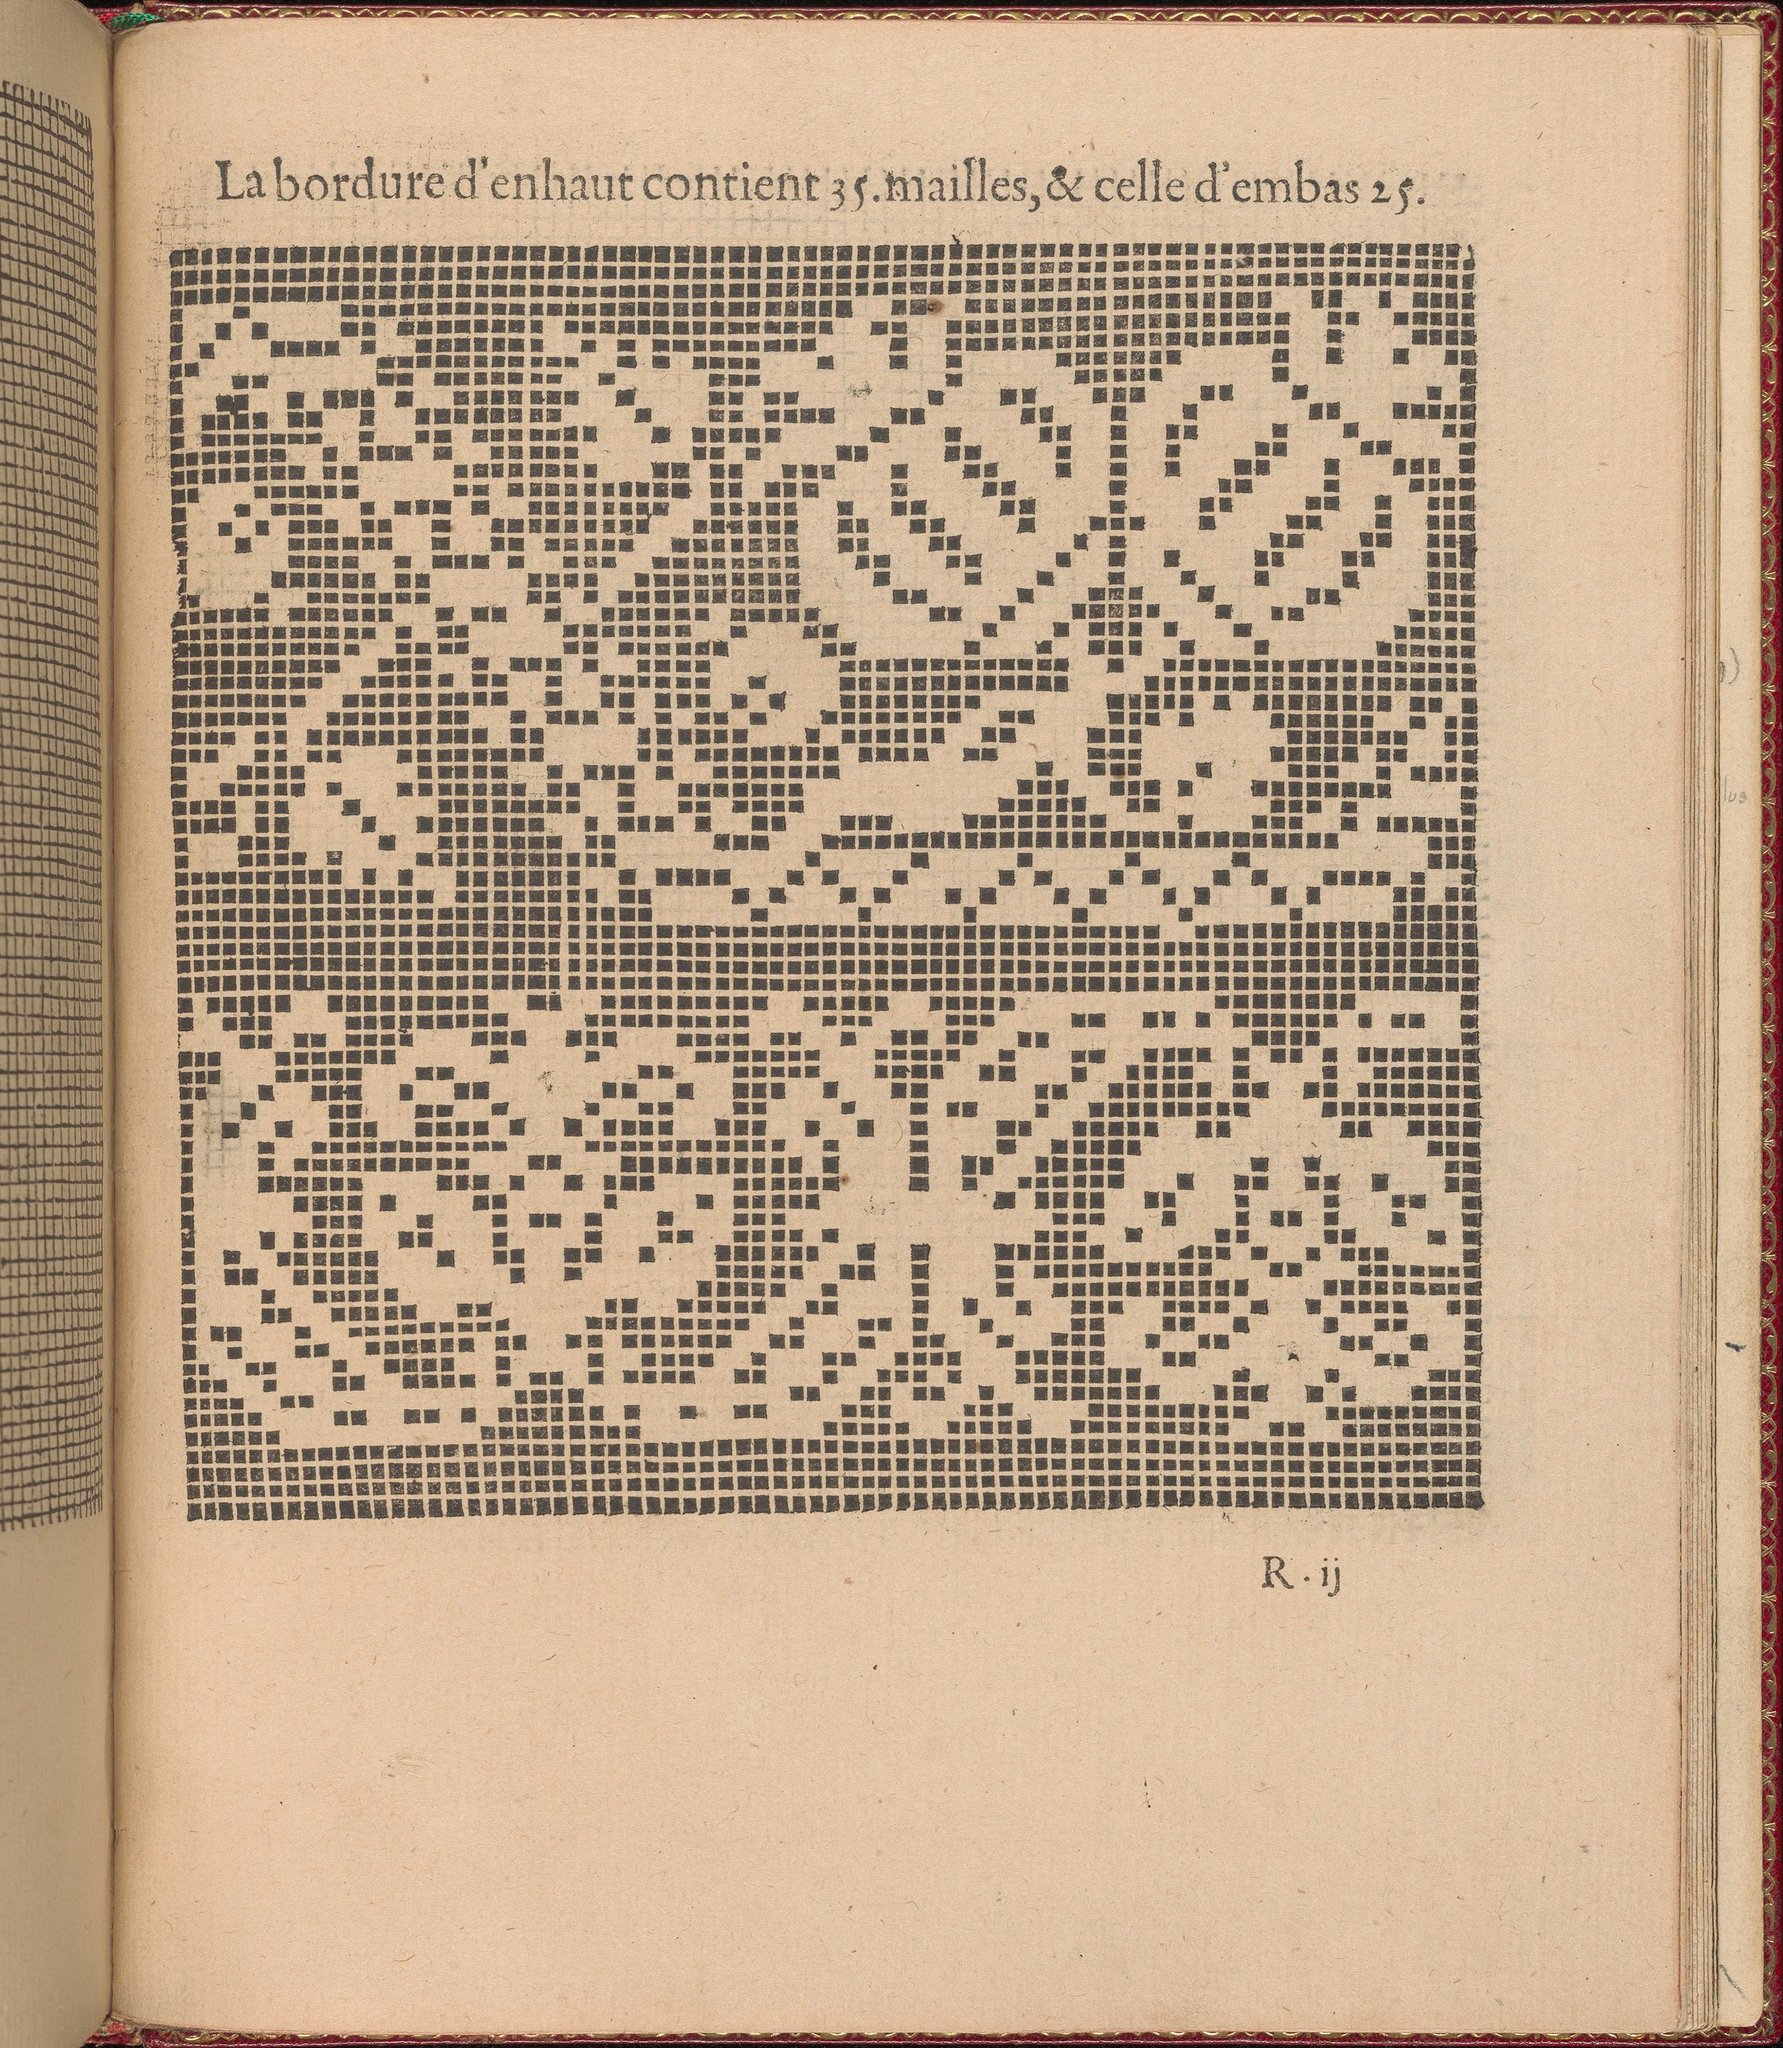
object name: book print ornament architecture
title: Les Singuliers et Nouveaux Portraicts... page 66 (recto)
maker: federico de vinciolo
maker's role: designer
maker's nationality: italian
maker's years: 1582-1599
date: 1588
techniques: woodcut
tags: fruit,flowers,vines